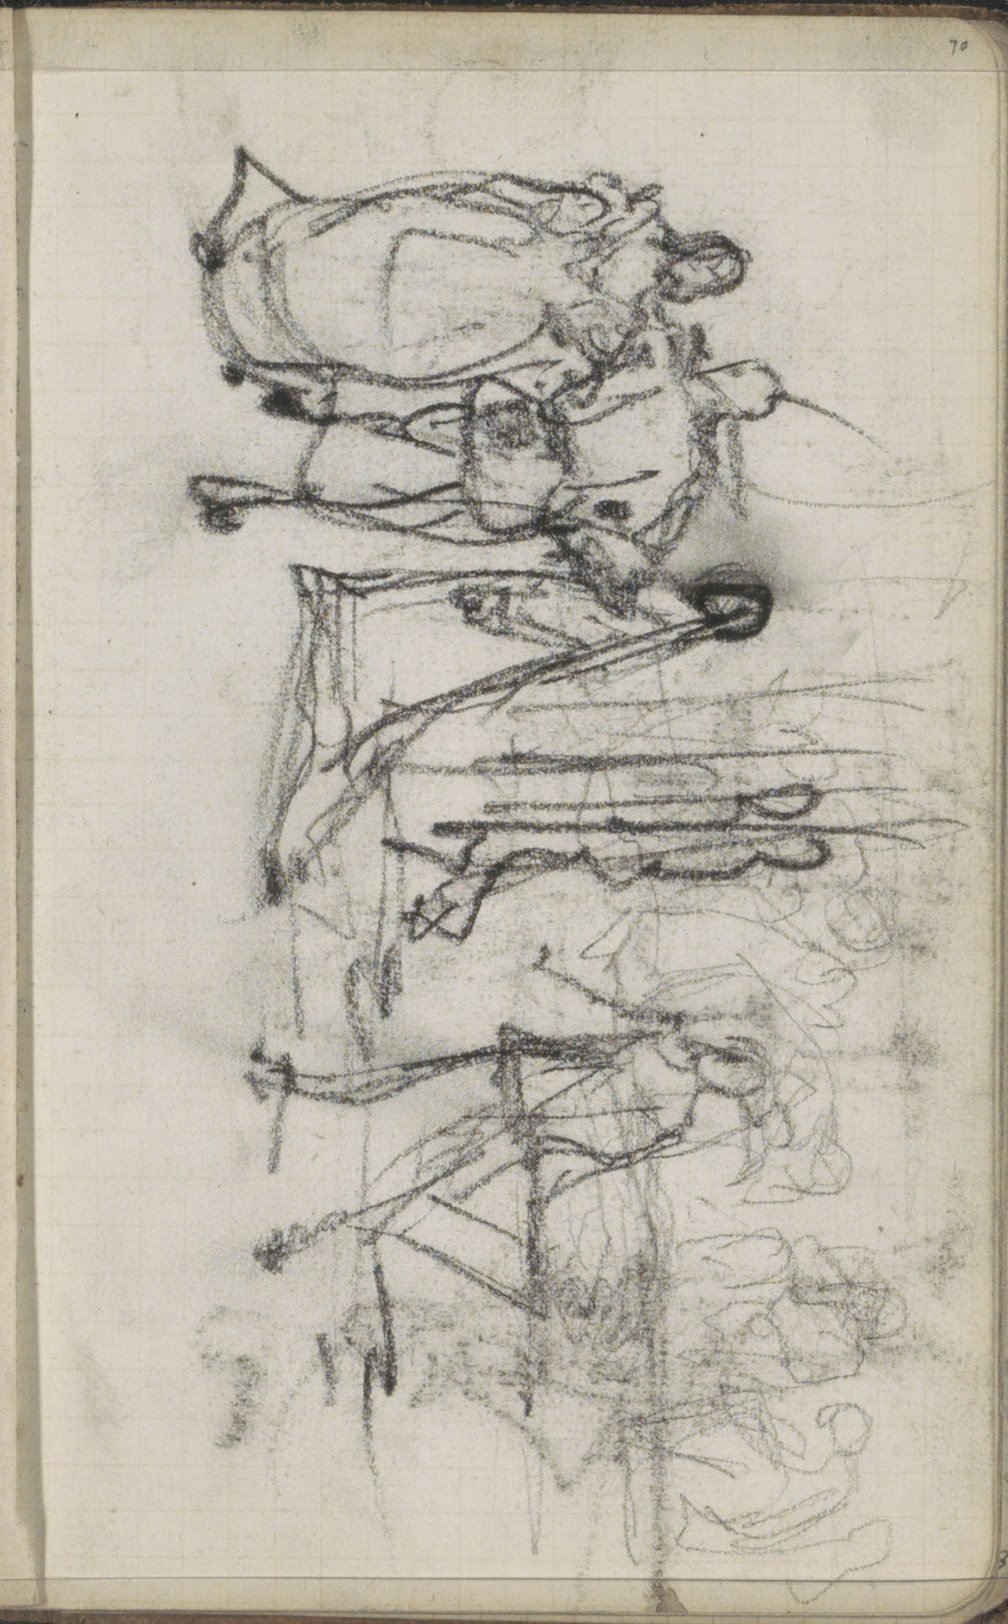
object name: sketchbook leaf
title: Figuren in historisch kostuum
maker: marius bauer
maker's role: draughtsman, print maker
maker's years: 1867-1932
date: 1879-1885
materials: chalk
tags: standing figure, historical costume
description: Vermoedelijk een scène uit een theaterstuk. Pagina 70 uit een schetsboek met 58 bladen.